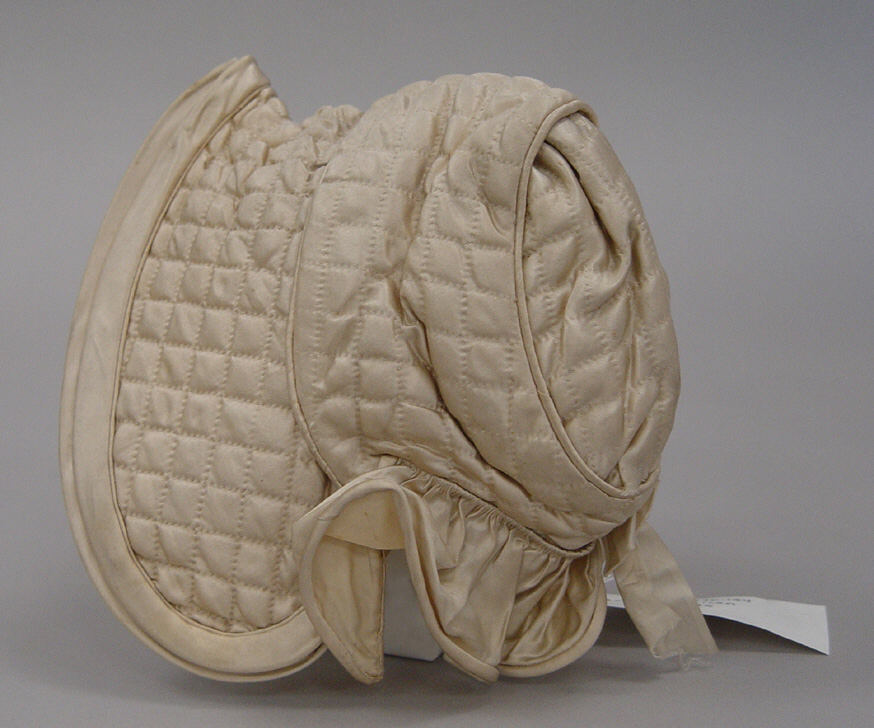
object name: bonnet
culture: american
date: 1835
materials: silk